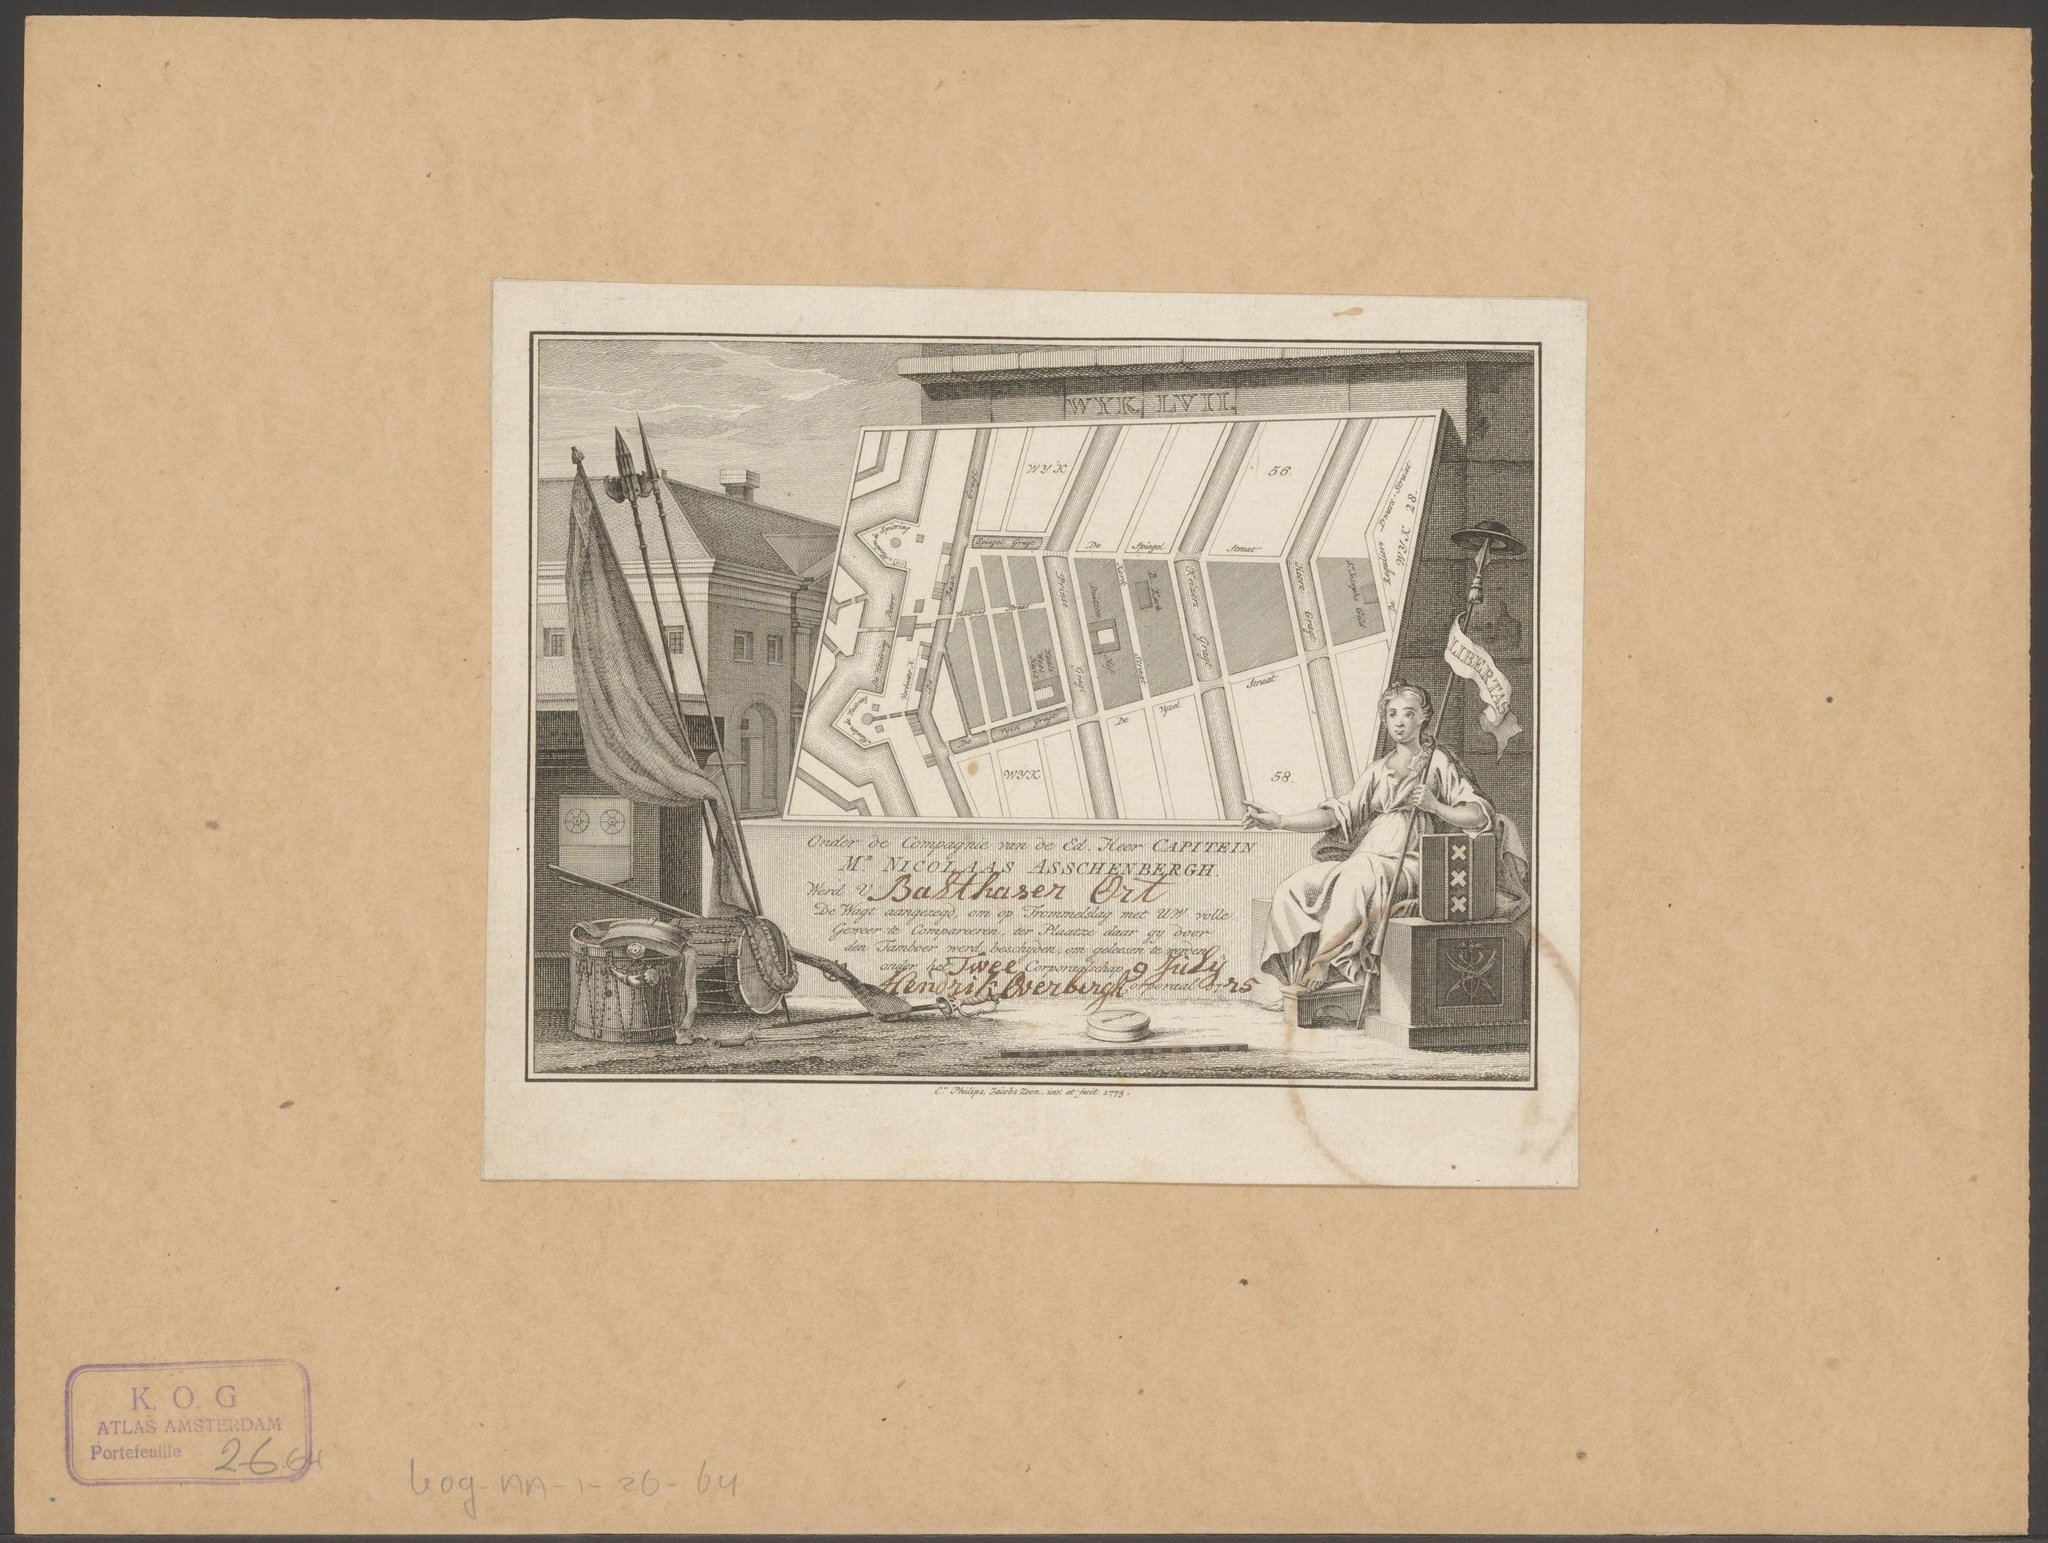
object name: print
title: Schuttersbrief van kapitein Nicolaas Asschenbergh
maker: caspar jacobsz. philips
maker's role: draughtsman, print maker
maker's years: 1732-1789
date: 1775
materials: chalk, paper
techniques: engraving, etching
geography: amsterdam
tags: amsterdam, coat of arms (as symbol of the state, etc.) (+ city; municipal), helved weapons, polearms (for striking, hacking, thrusting): lance, drum (musical instrument), freedom, liberty; 'libertà' (ripa), maps of cities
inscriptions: collector's mark: Lugt 1641b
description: Schuttersbrief met oproep van kapitein Nicolaas Asschenbergh, gericht aan Balthaser Ort, om zich bij het tweede korporaalschap van Hendrik Overbergh van burgerwijk LVII te Amsterdam te melden op 9 juli 1775. Voorgedrukte brief met open delen die in pen zijn ingevuld. Onderwerpsrubriek binnen de Atlas Amsterdam: Schutters-oproepingsbriefjes.